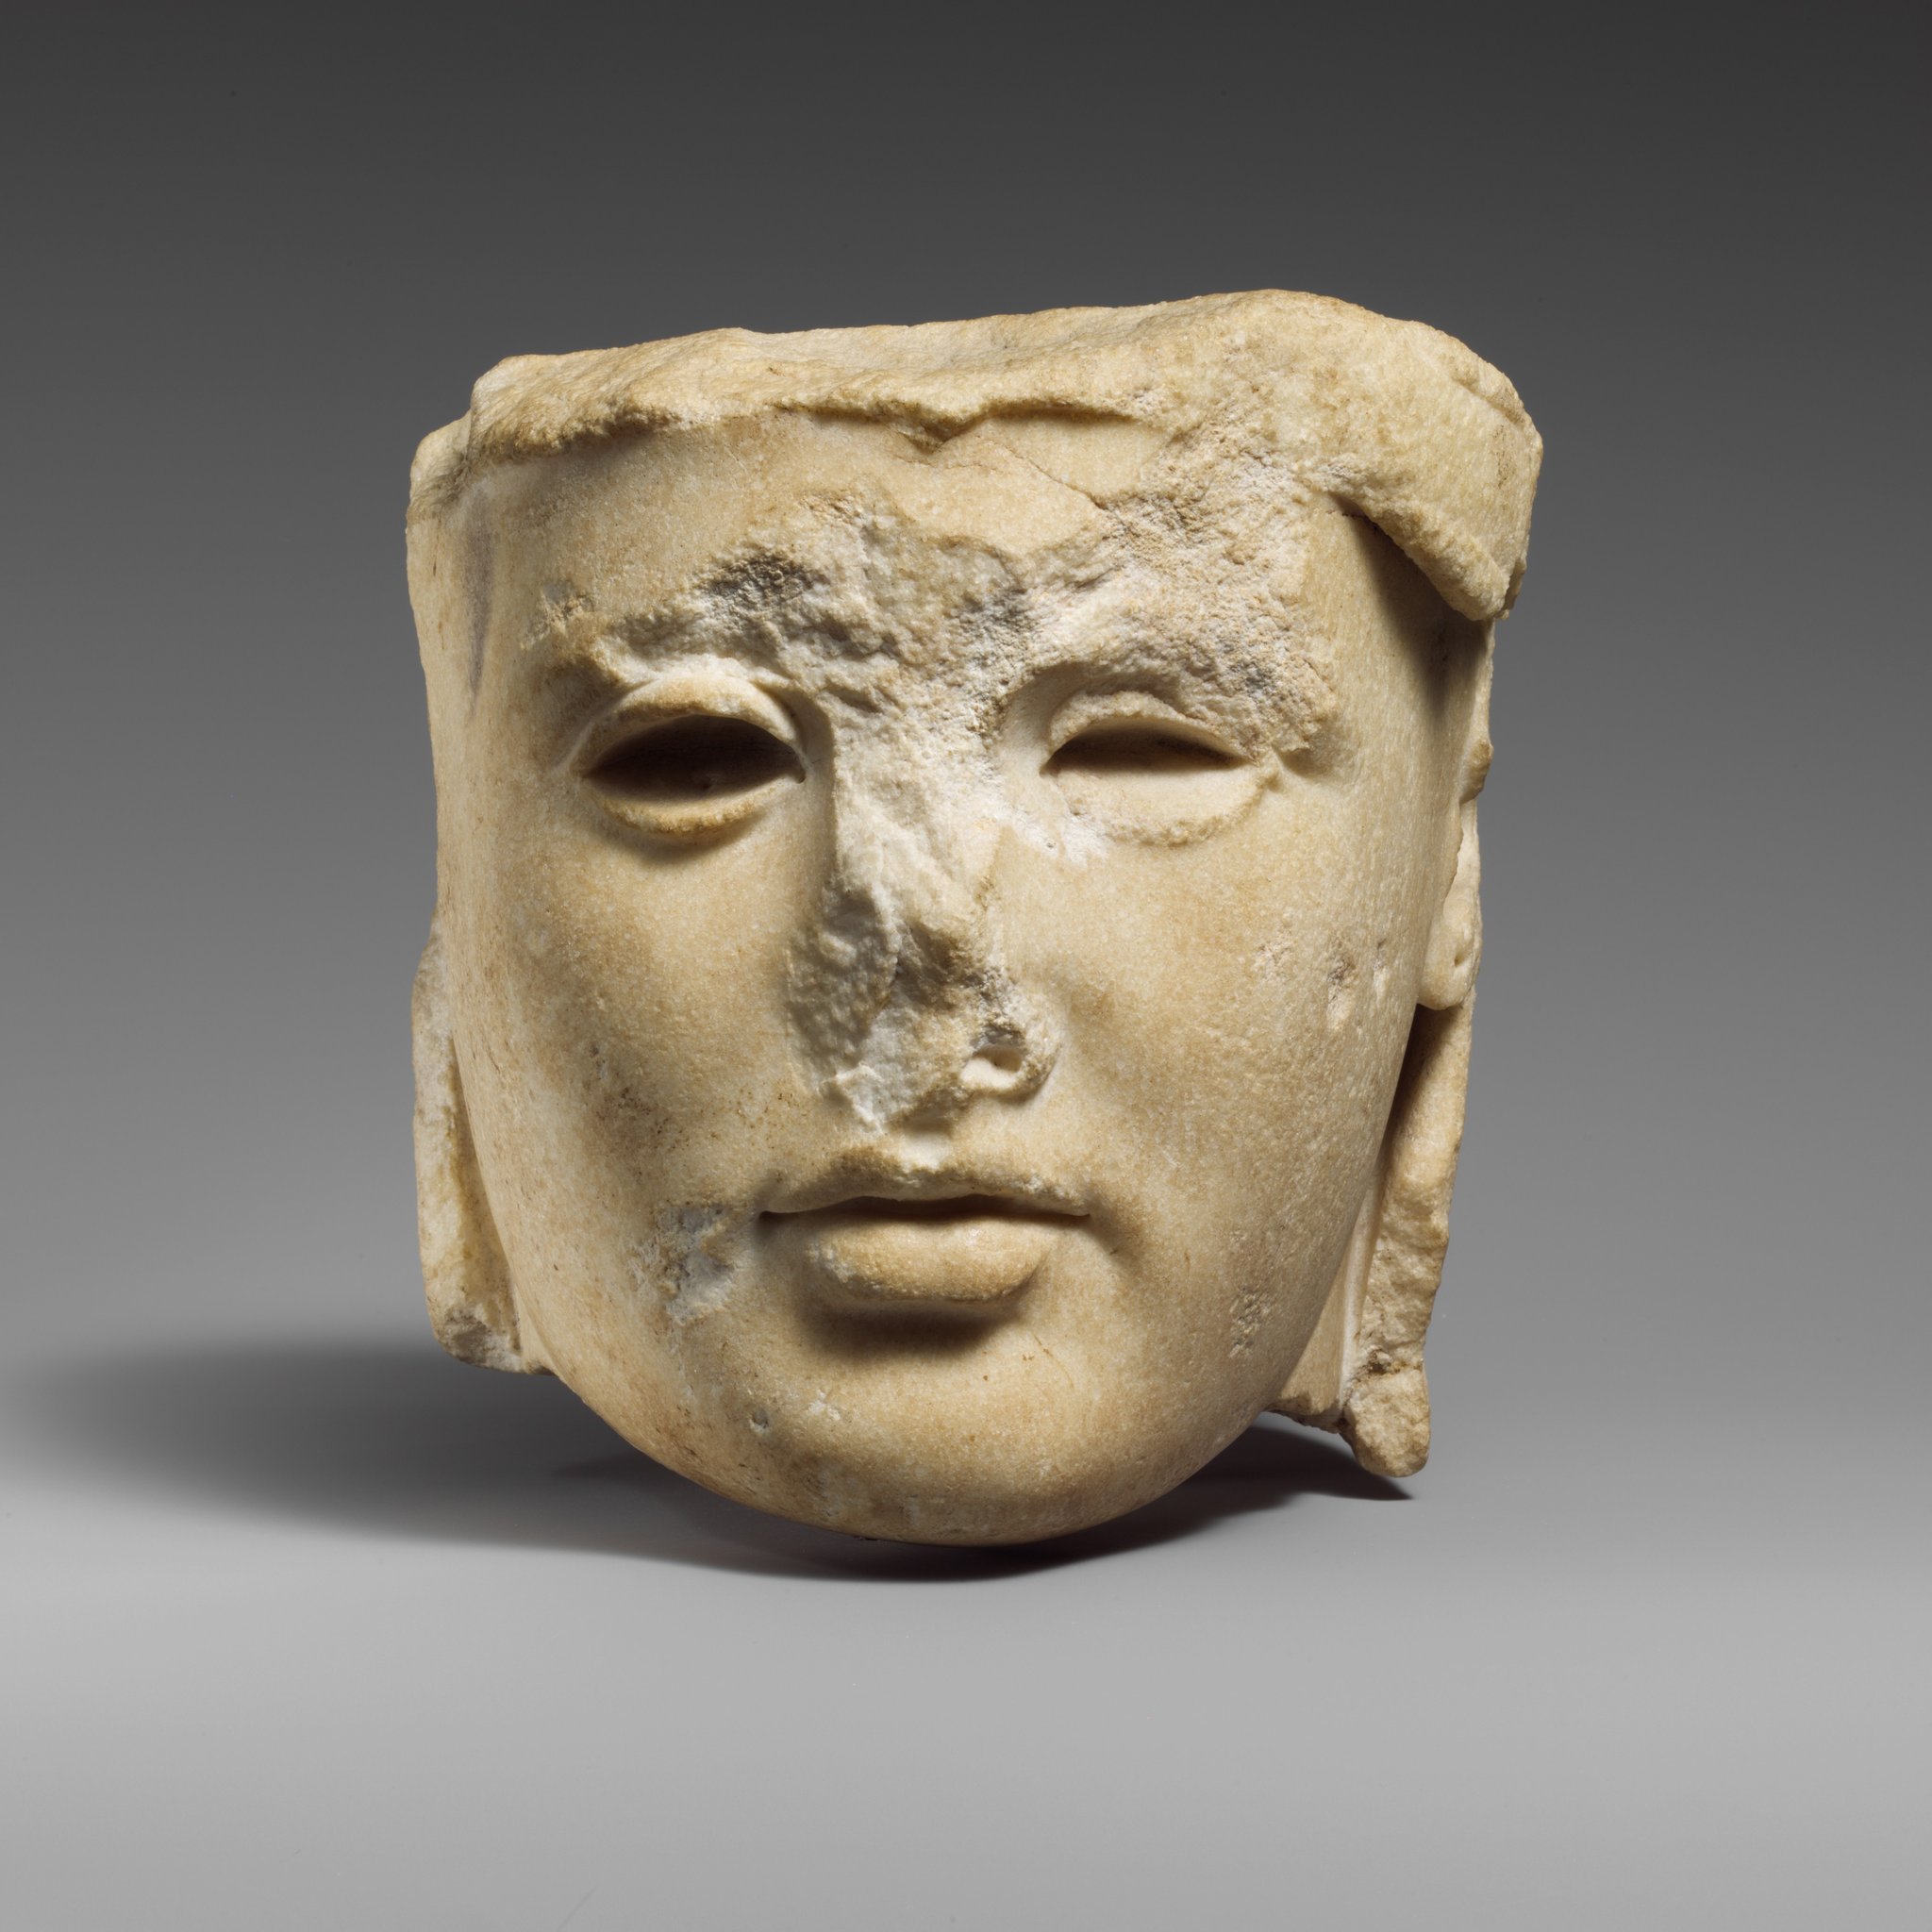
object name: head of athena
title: Marble head of Athena: The so-called Athena Medici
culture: roman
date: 138-192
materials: marble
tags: heads,athena